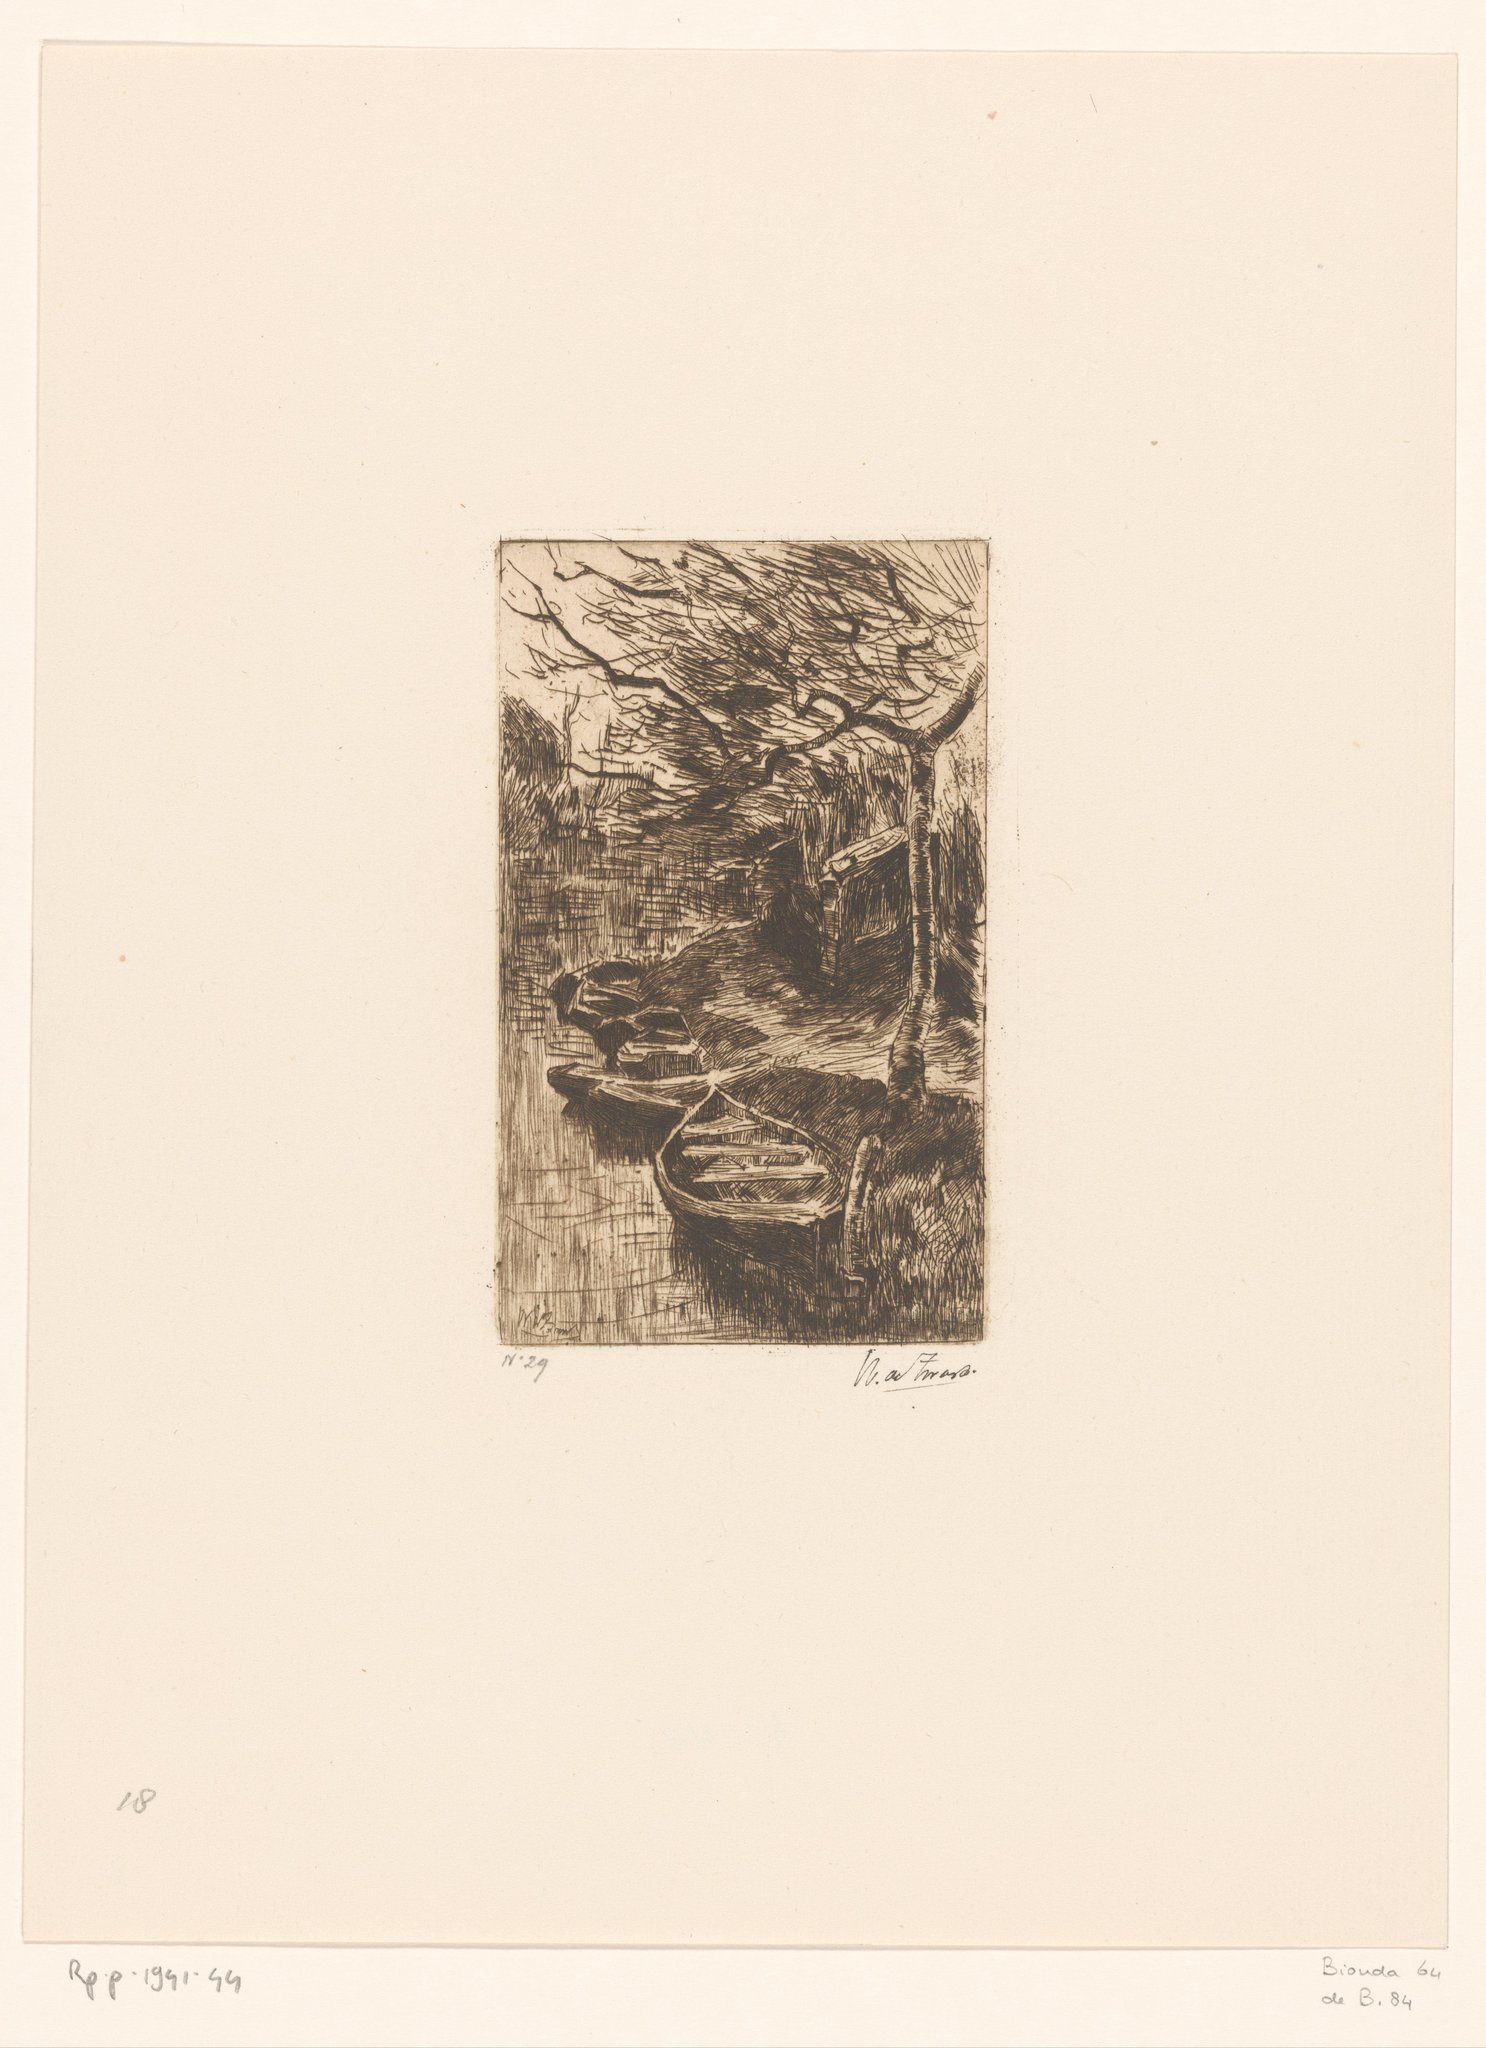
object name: print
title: Botenverhuur 'Roeilust' (Loosduinse vaart)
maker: willem de zwart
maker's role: draughtsman, painter, print maker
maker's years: 1862-1931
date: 1896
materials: paper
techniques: drypoint, etching, intaglio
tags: canal, rowing-boat, canoe, etc.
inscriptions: collector's mark: Lugt 2228, collector's mark: Lugt 2760